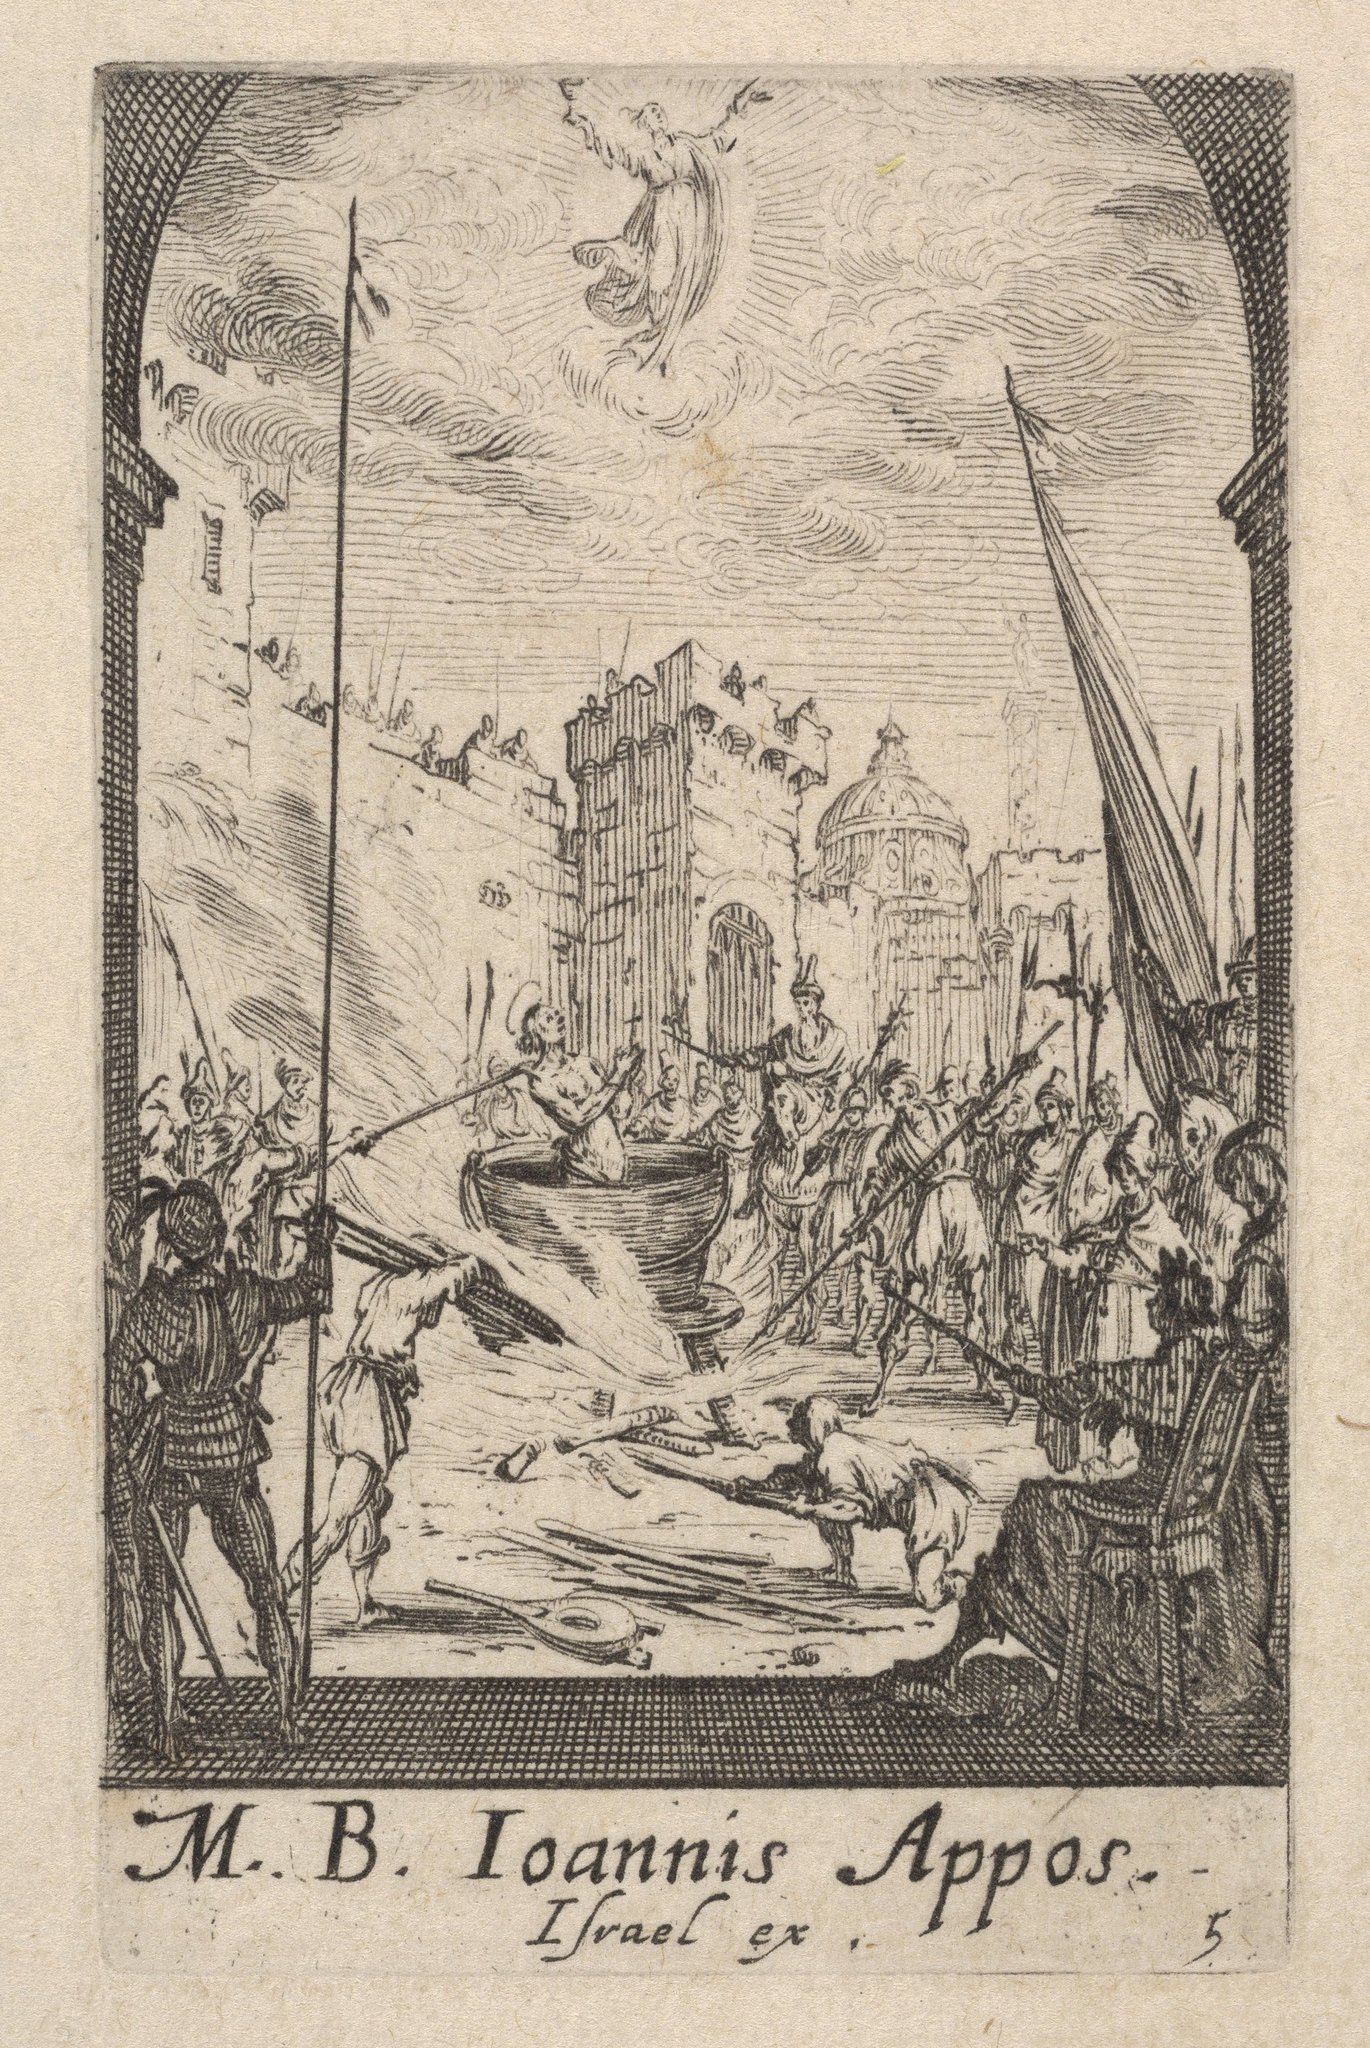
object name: print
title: Martyrdom of Saint John the Evangelist, from "The Little Apostles" (Les Petits Apôtres)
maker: jacques callot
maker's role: artist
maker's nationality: french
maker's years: 1592-1635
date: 1632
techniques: etching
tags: saint john the evangelist